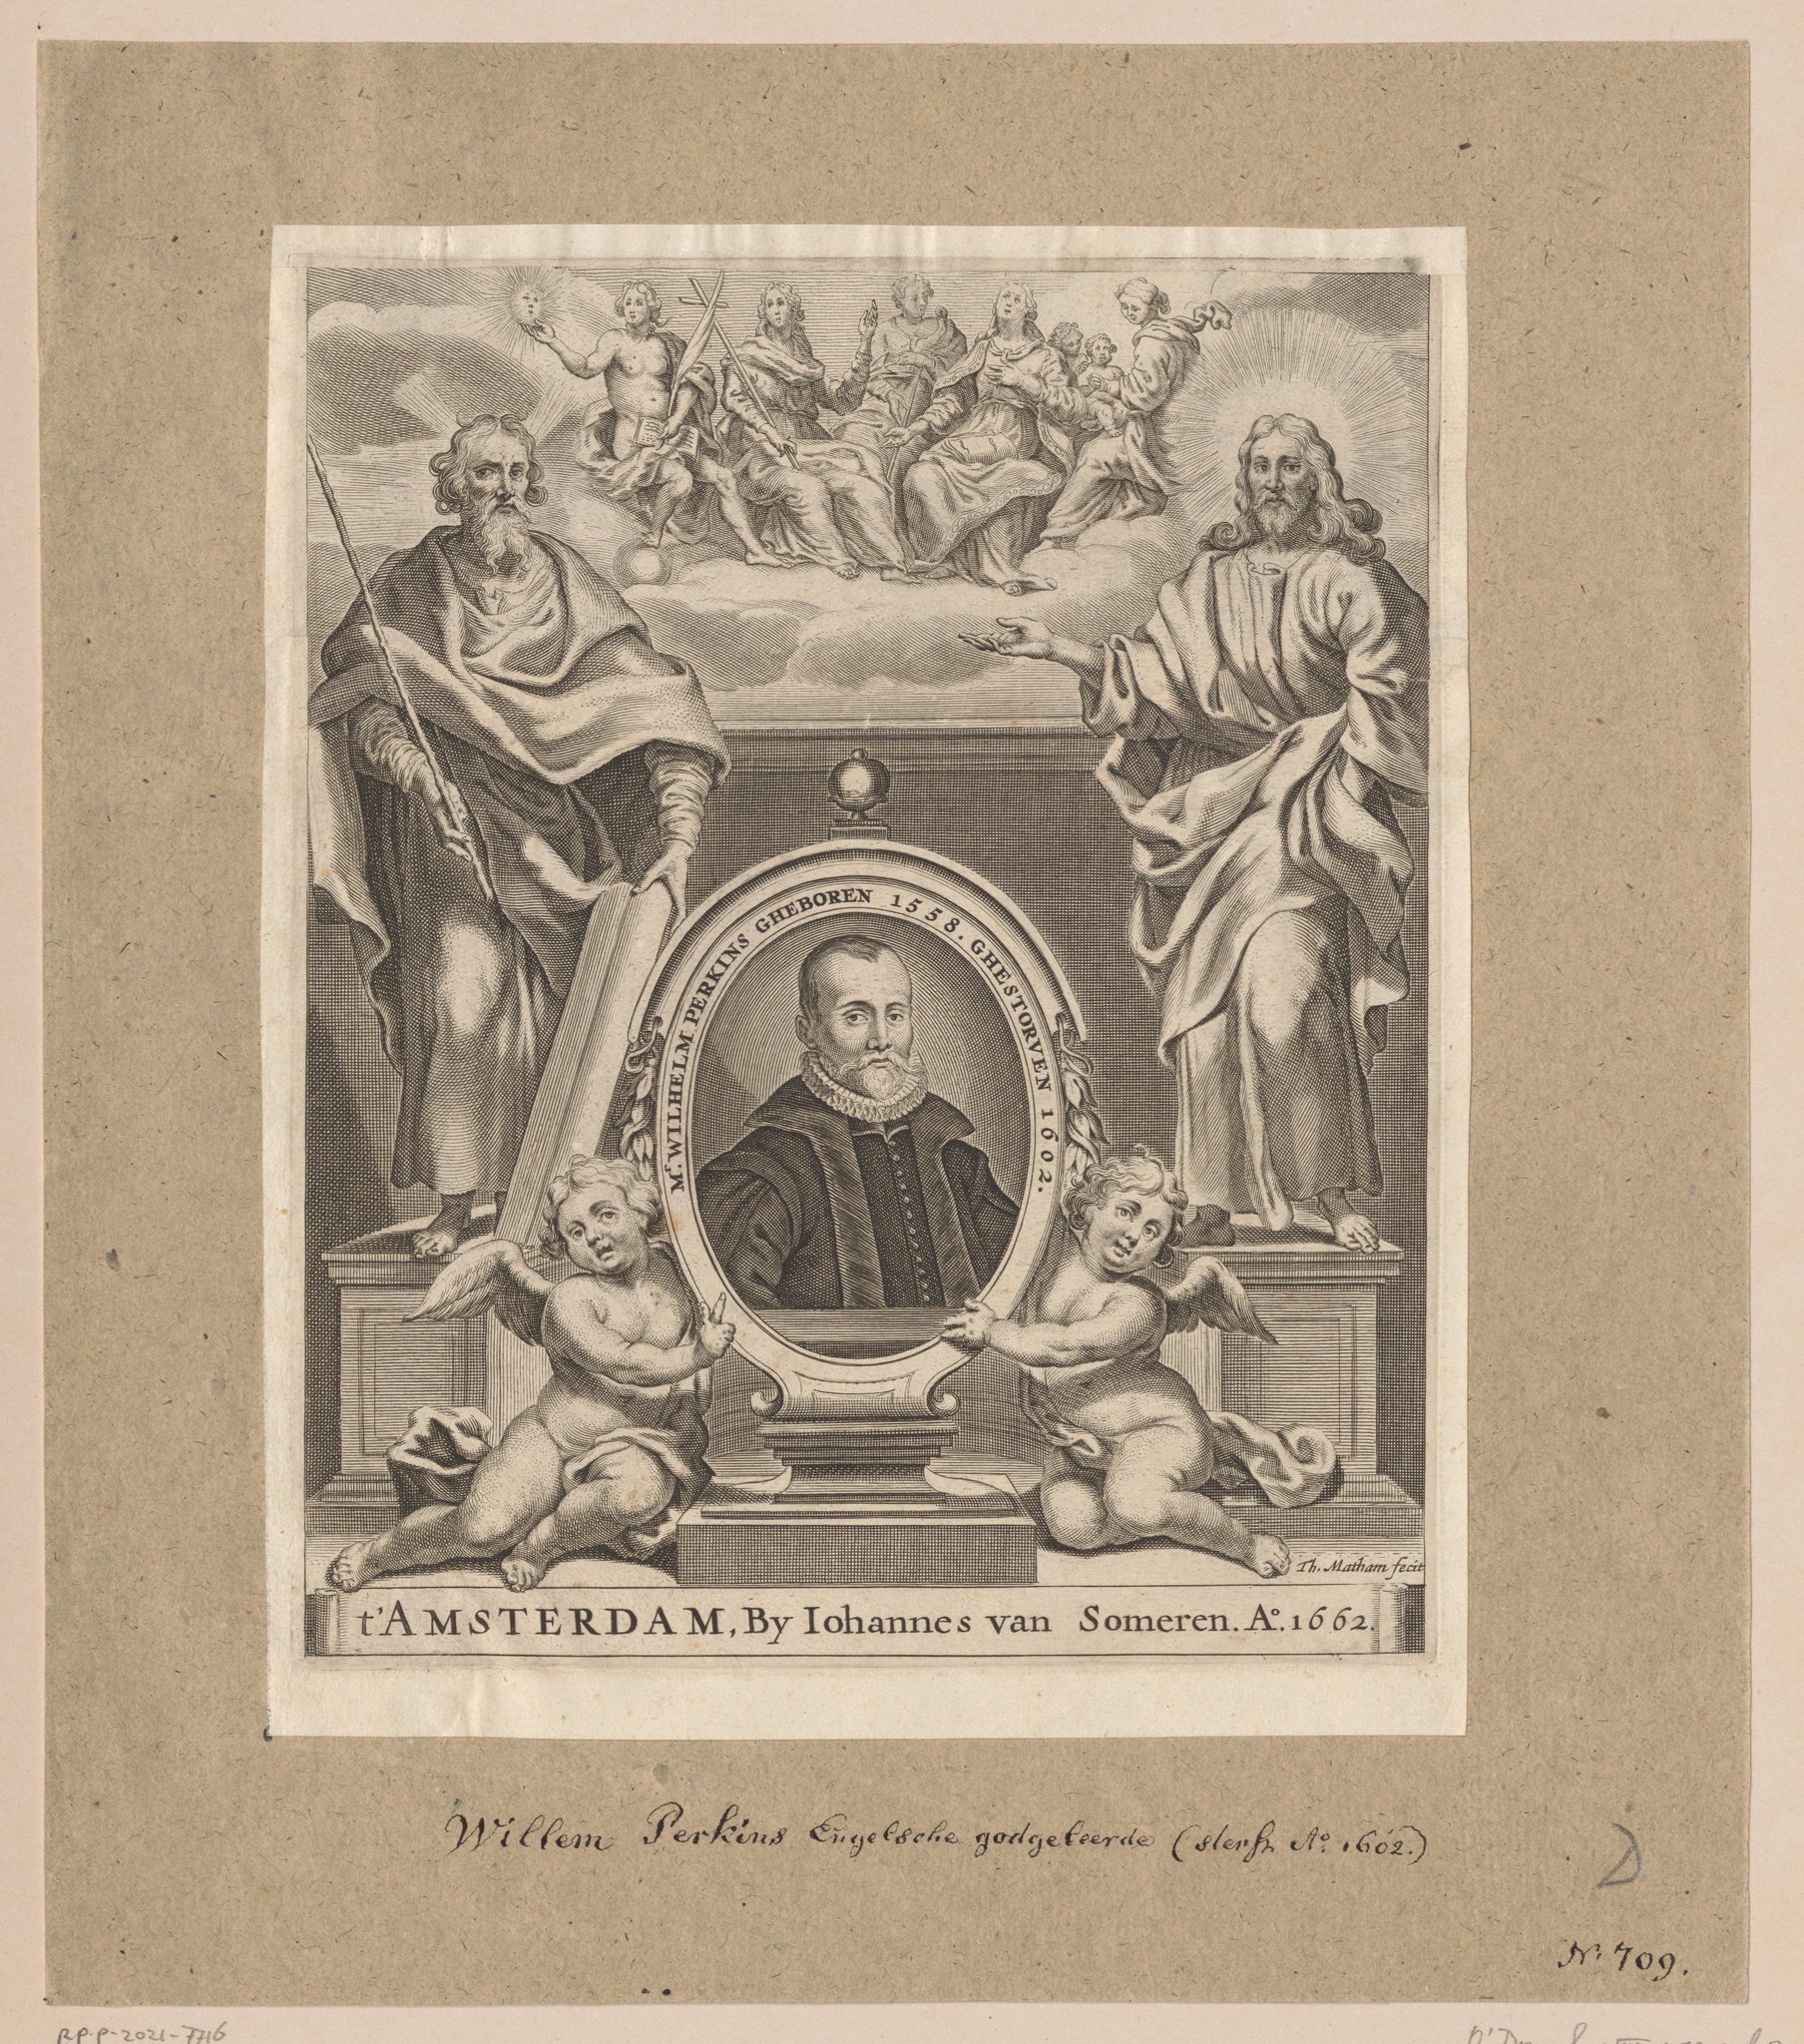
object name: titelblad, titelpagina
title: Portret van William Perkins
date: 1662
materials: paper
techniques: engraving, etching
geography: amsterdam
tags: the three theological virtues, historical persons, moses (not in biblical context); possible attributes: rays of light or horns on his head, rod, tables of the law, angel(s) represented as child(ren), 'portraits' of christ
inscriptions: date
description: Titelpagina voor: Perkins, Wiliam. Alle de werken. [vertaald door] Hendrik Uilenbroek. 3 dln. Amsterdam: Joannes van Someren, 1662, dl. 3. Deze prent is bovenaan afgesneden en weer gedeeltelijk aan elkaar geplakt; hierdoor lijkt de plaatrand ingekort.